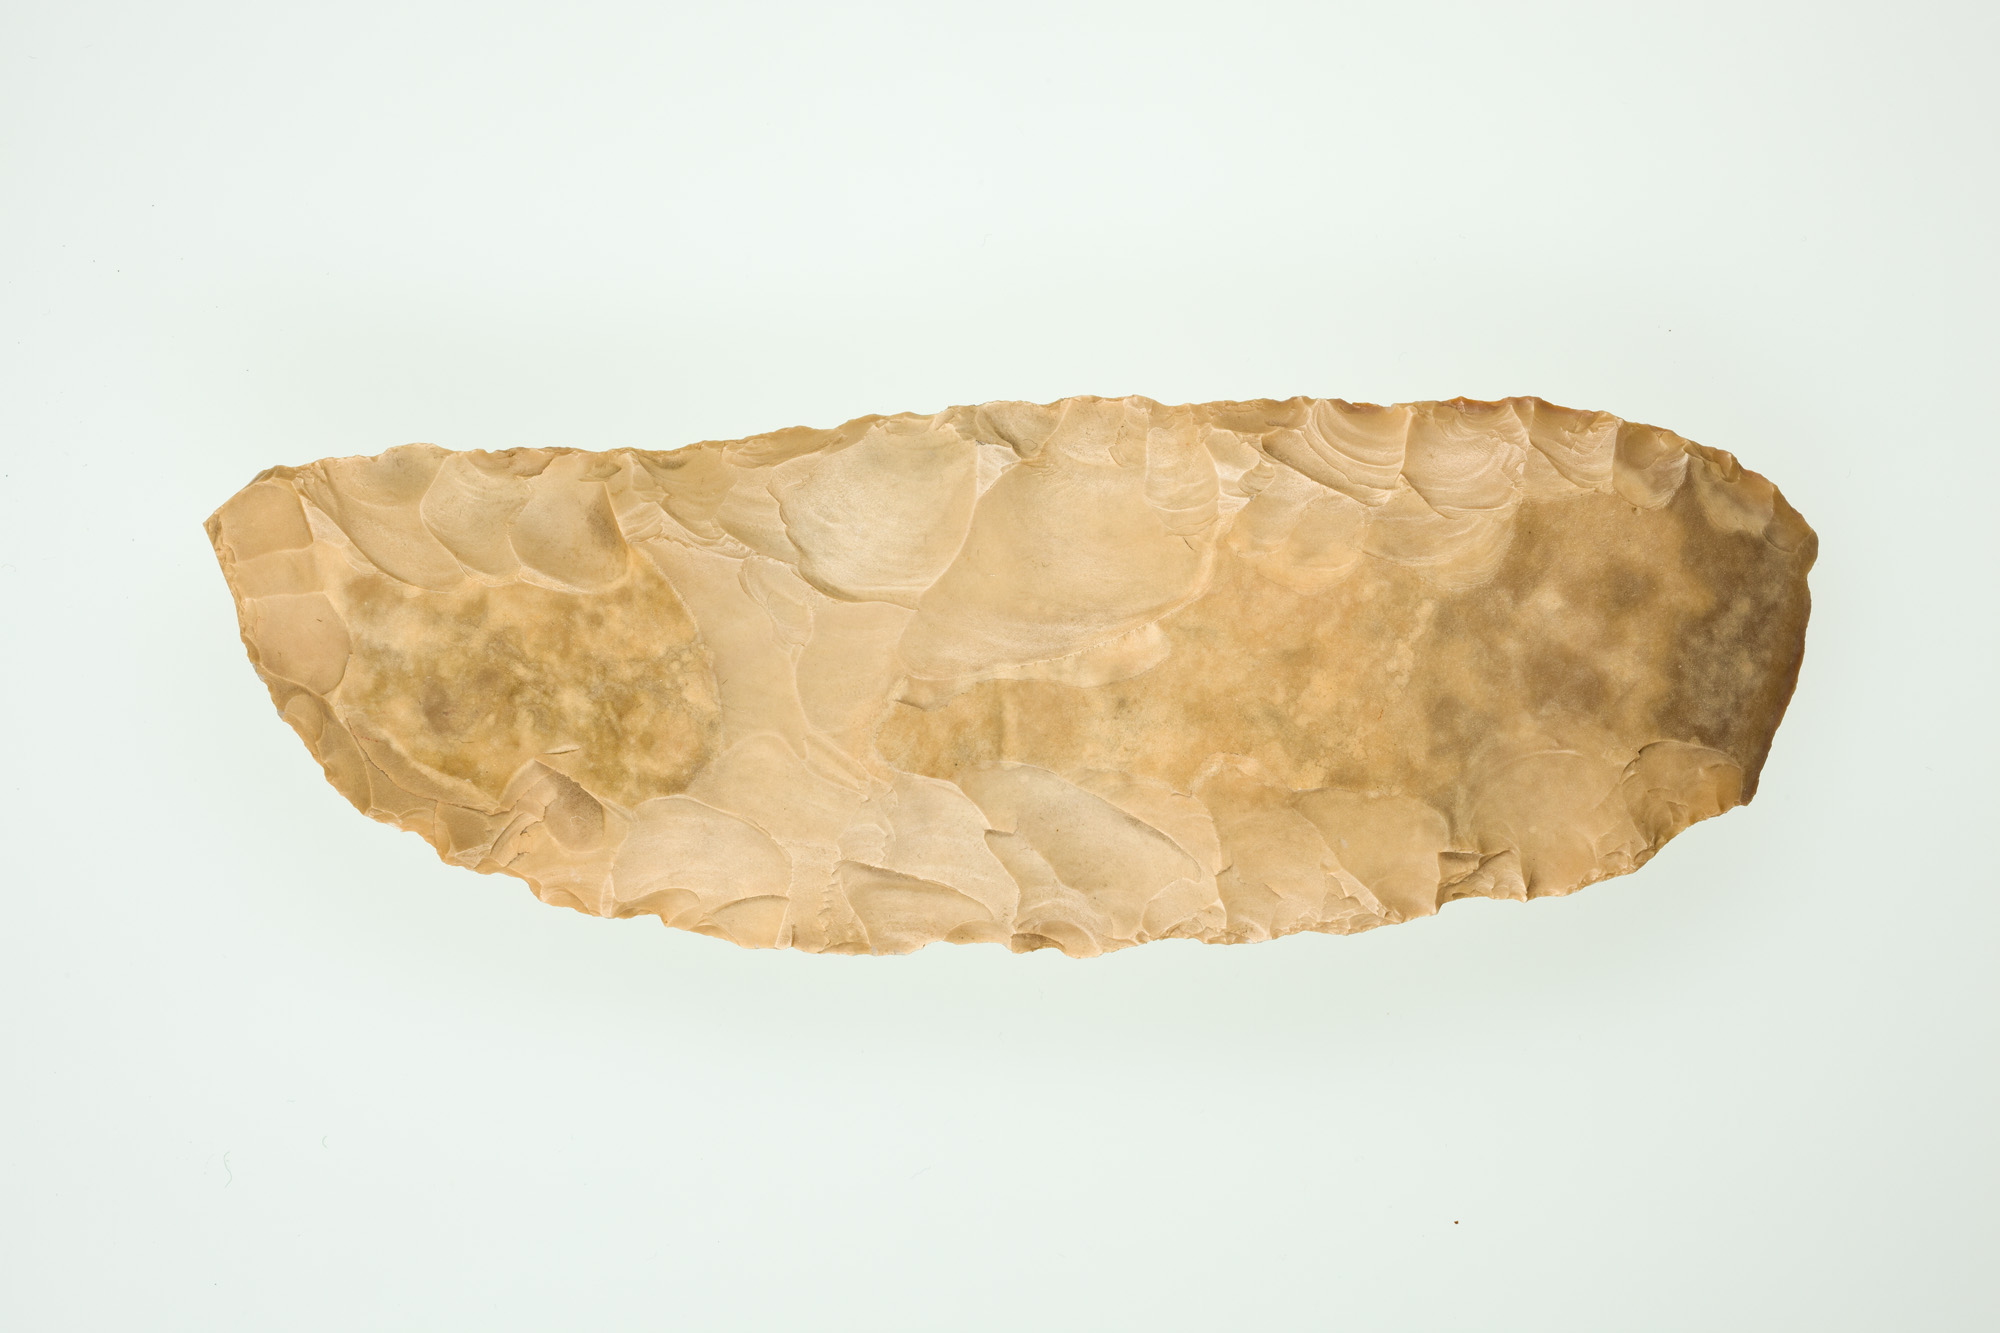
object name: knife, bifacial knife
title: Bifacial Knife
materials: stone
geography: egypt